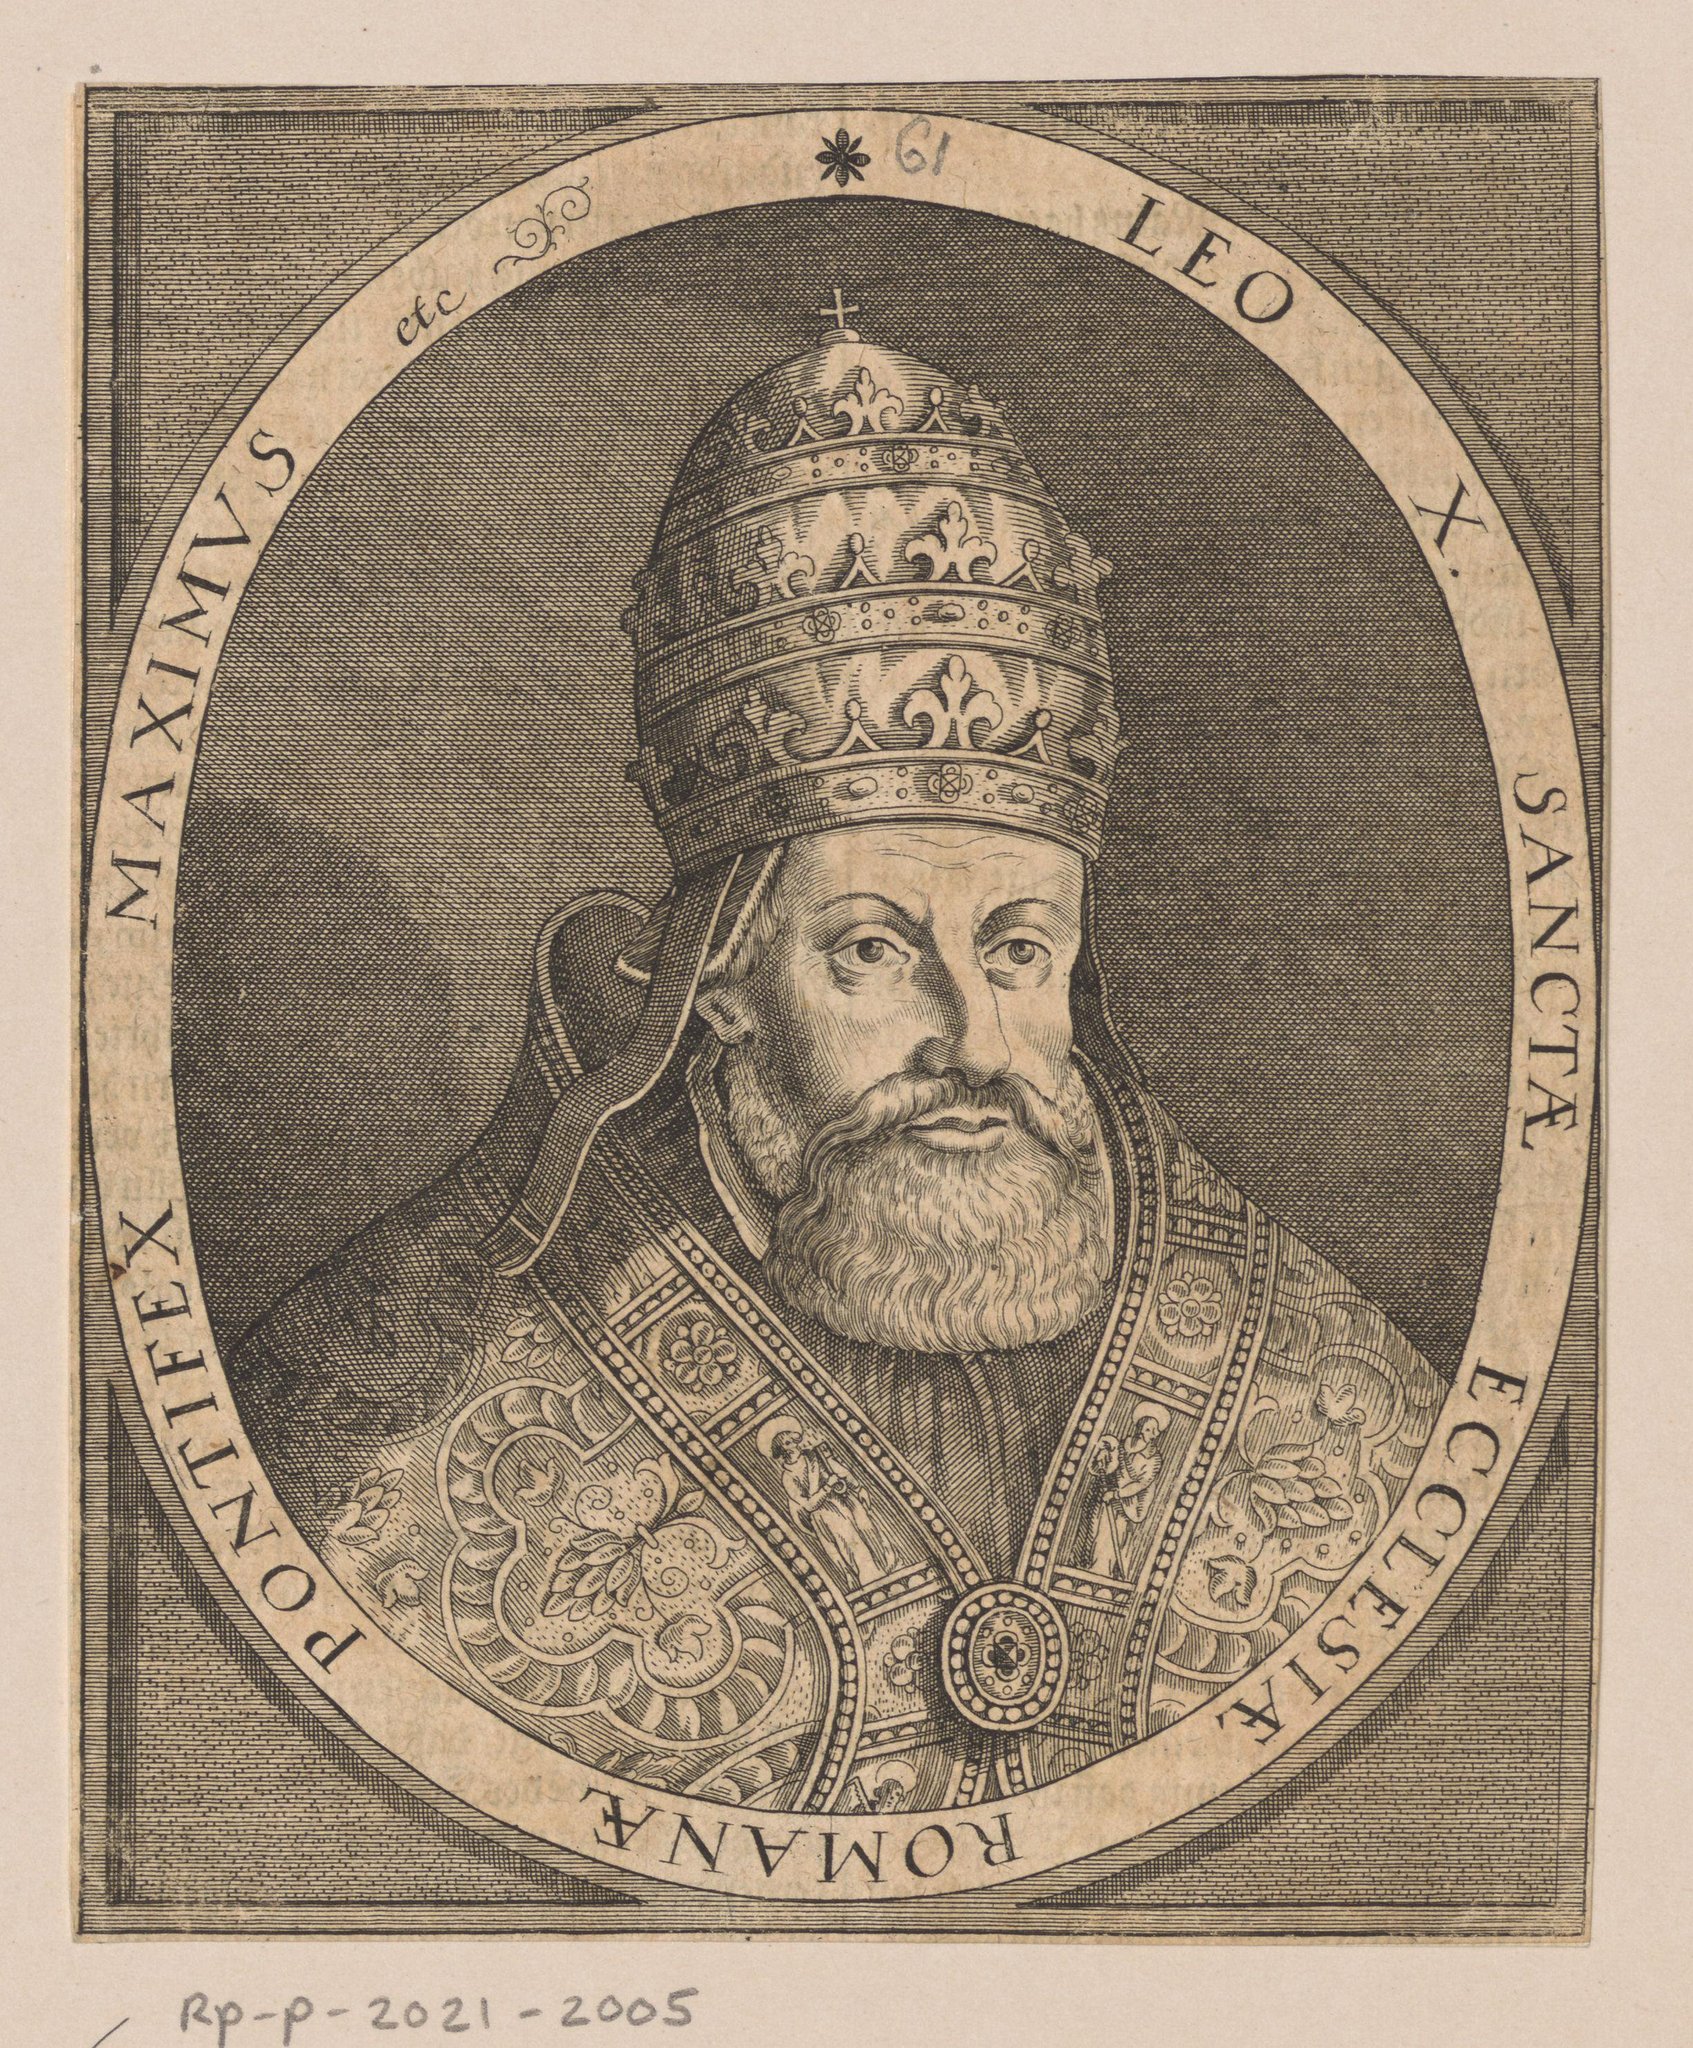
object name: print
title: Leo X. Sanctae Ecclesiae Romanae Pontifex Maximus etc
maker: Anonymous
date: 1681-1730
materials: paper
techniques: engraving, etching, letterpress printing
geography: italy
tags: leo xi, insignia of the pope, e.g. tiara, historical persons, pope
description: Volgens de tekst rondom het portret gaat het hier om paus Leo X. Waarschijnlijker is echter dat dit een portret is van paus Leo XI. Prent komt uit een onbekende publicatie.